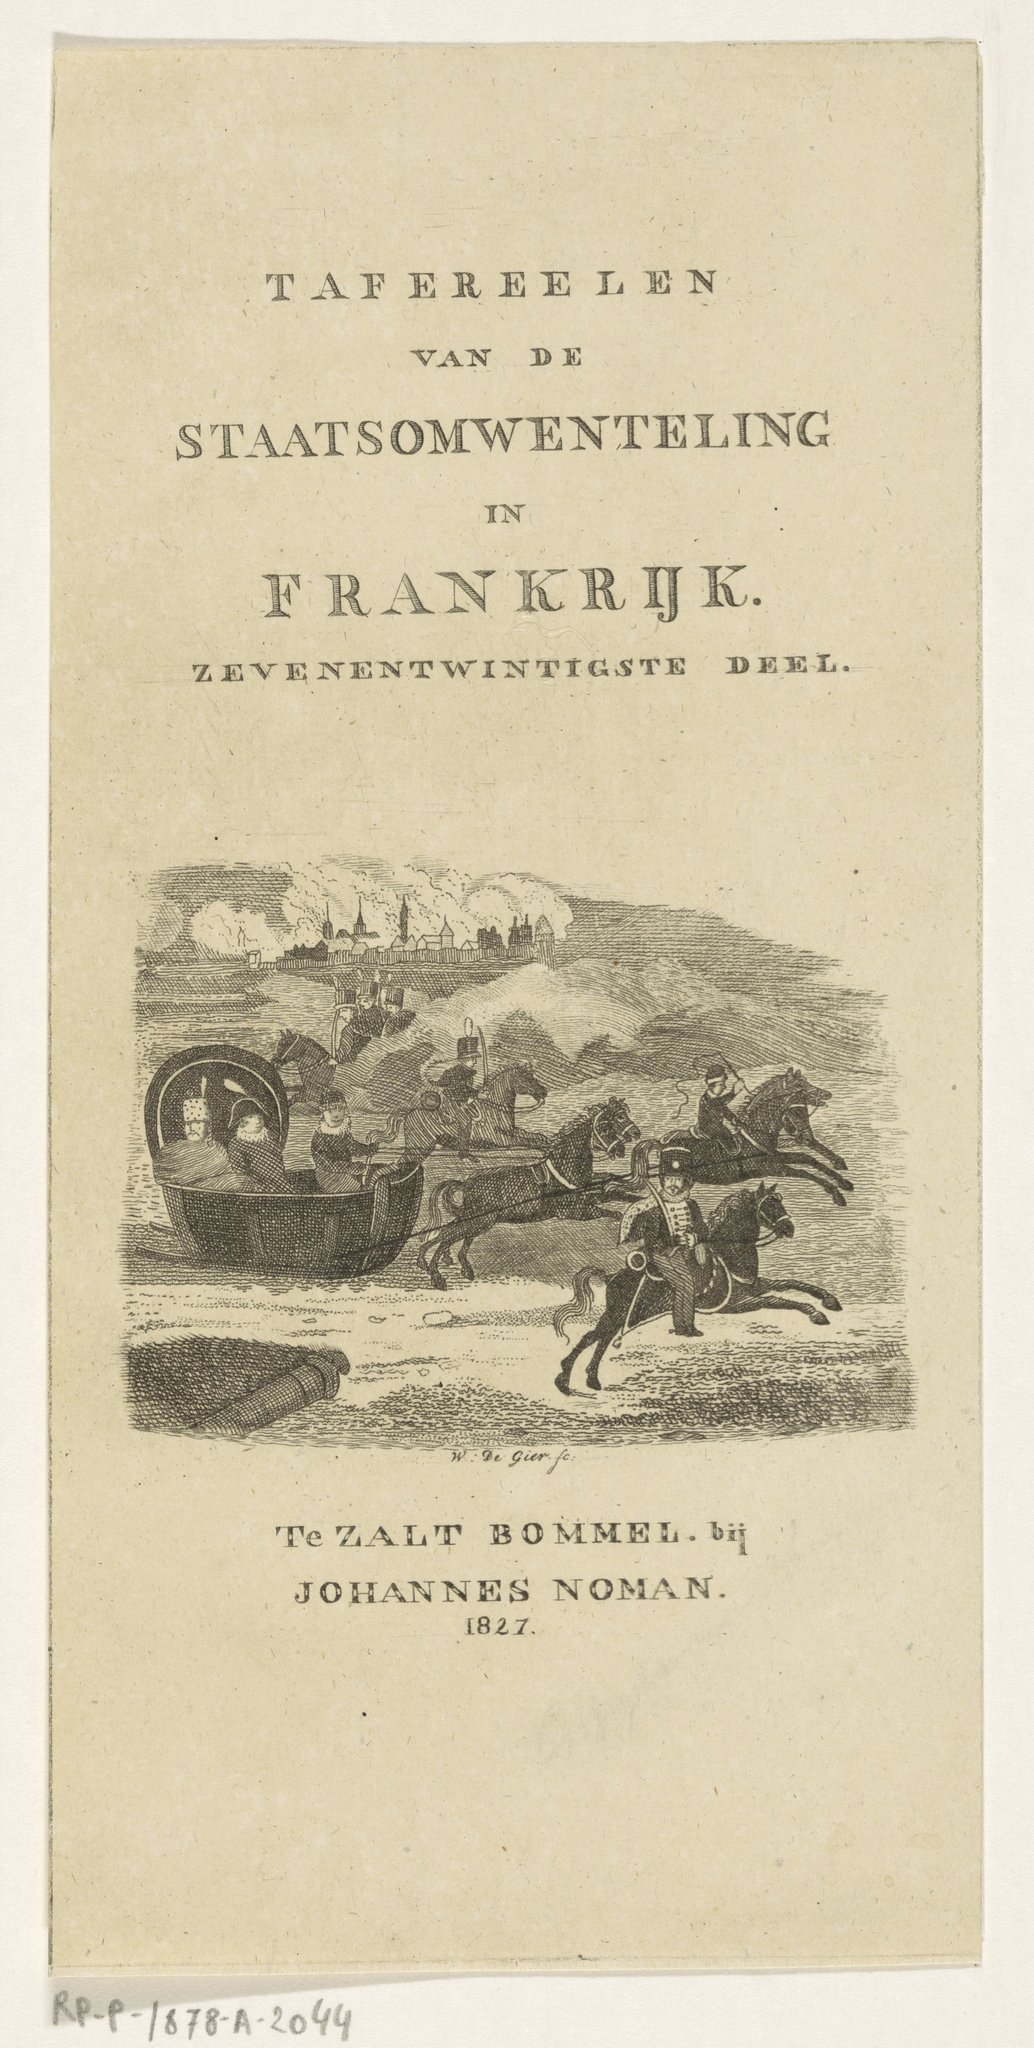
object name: print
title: Titelpagina voor Johan Konijnenburg en Martinus Stuart, Taferelen van de staatsomwenteling in Frankrijk, 1827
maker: willem de gier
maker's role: print maker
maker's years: 1811-1890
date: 1827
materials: paper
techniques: etching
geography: zaltbommel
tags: napoleon i (emperor of the french), animal-drawn sledge (dutch: 'toeslede')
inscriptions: collector's mark: Lugt 2228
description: Centraal bovenaan de titel van het boekwerk. In het midden een voorstelling van de terugtocht van Napoleon uit Rusland. Napoleon zit in een door een paard getrokken slede en vlucht naar Frankrijk om een staatsgreep te verhinderen.